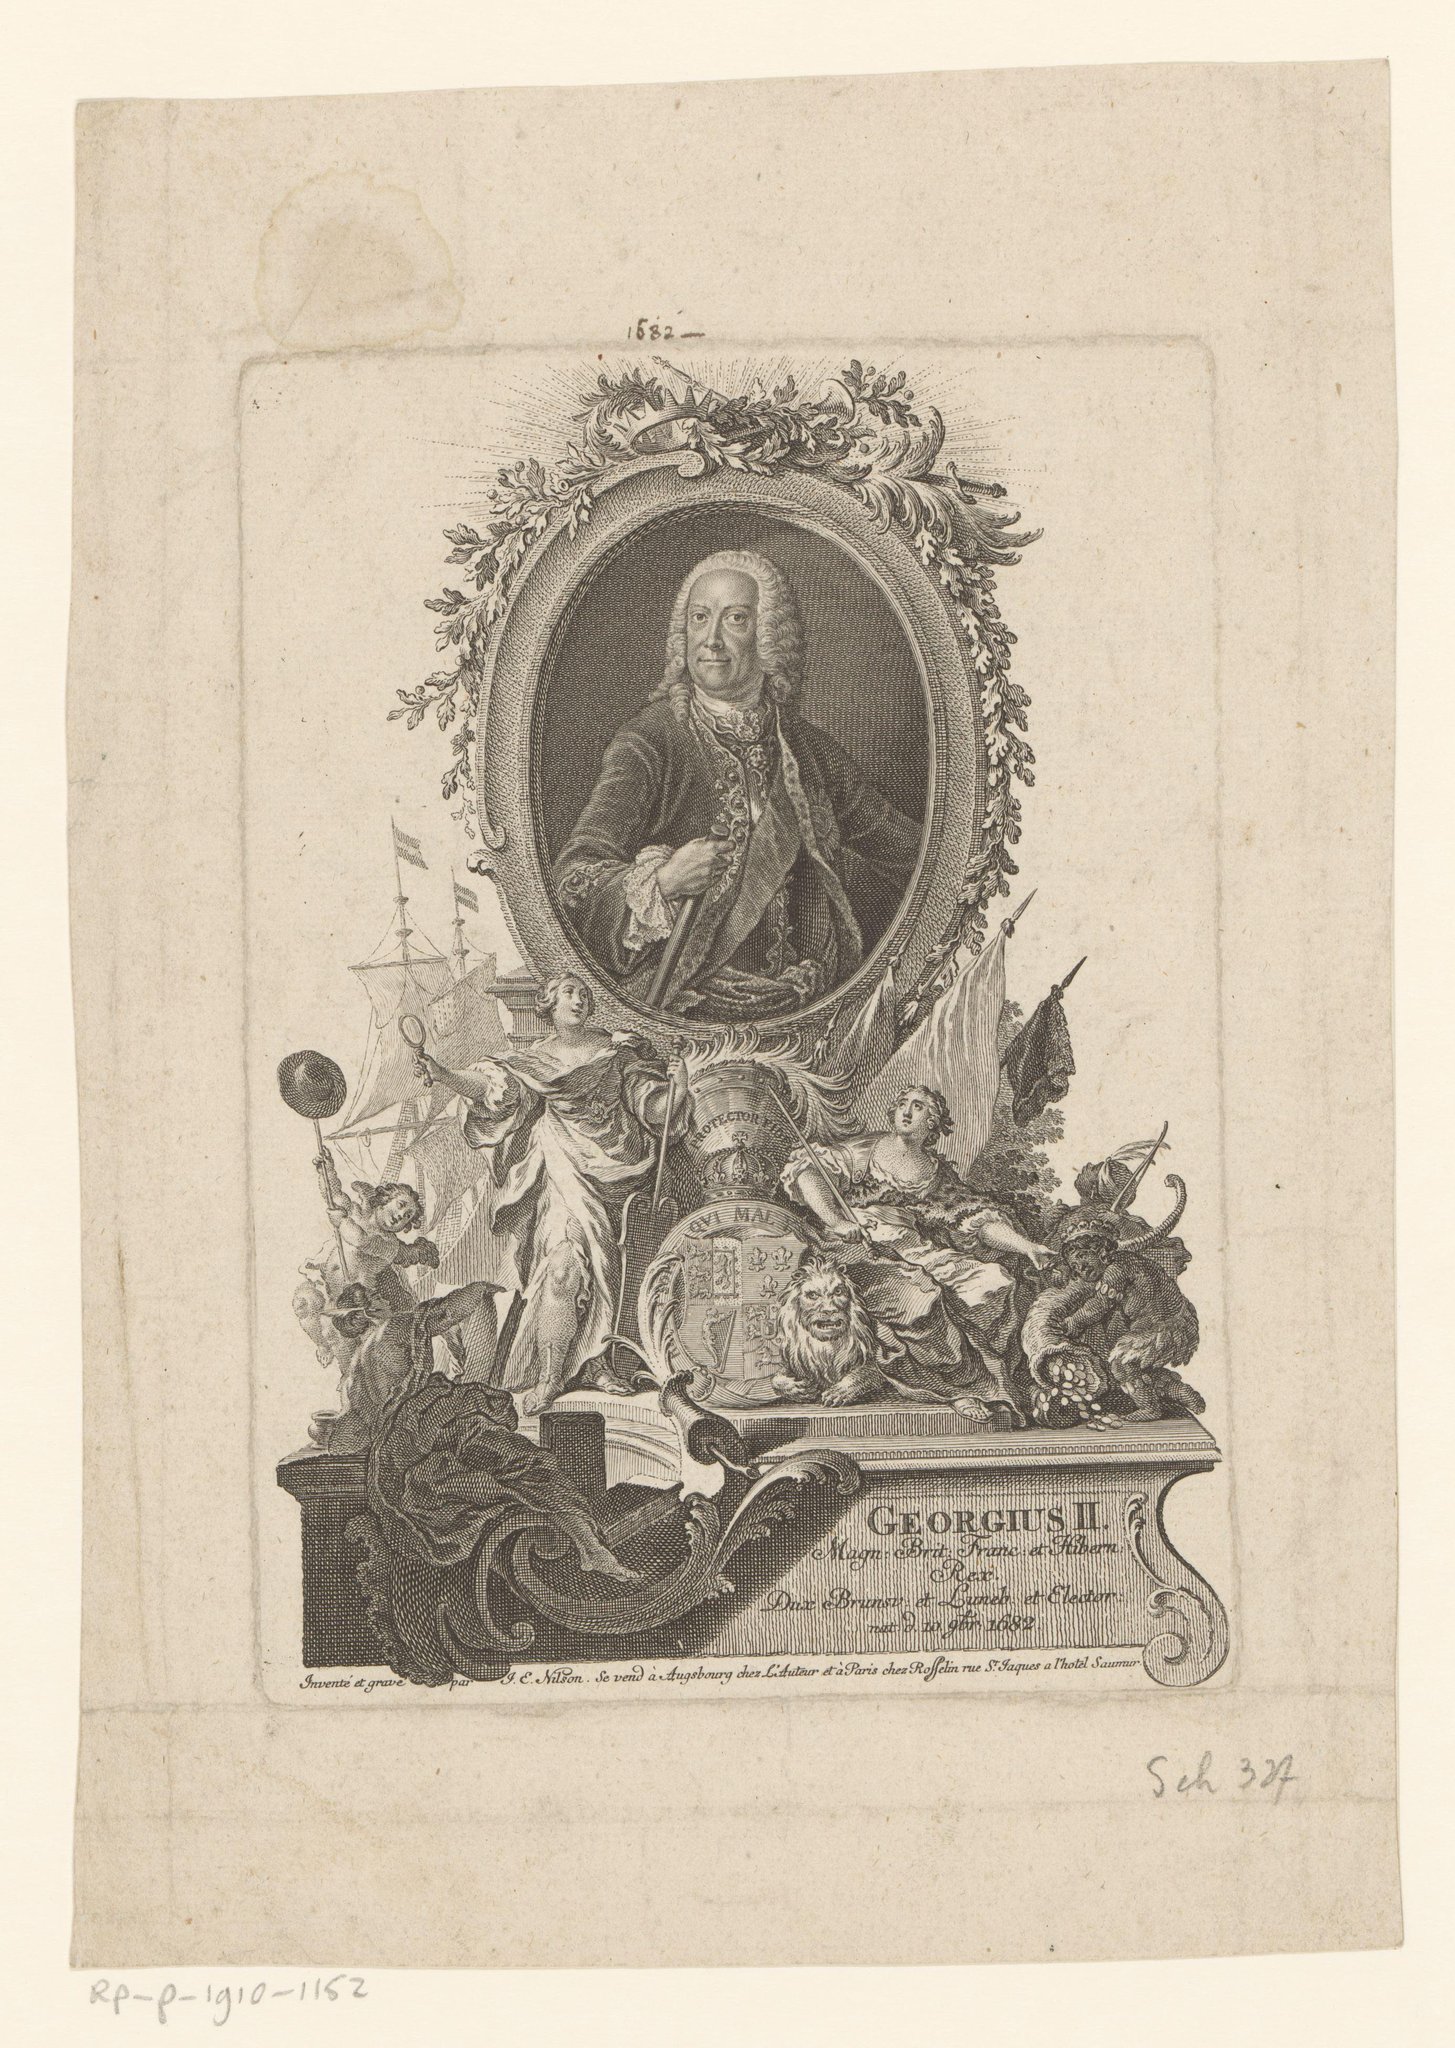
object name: print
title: Portret van George II, koning van Groot-Brittannië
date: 1731-1788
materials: paper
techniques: engraving, etching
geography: augsburg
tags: london, 'cornucopia', horn of plenty, sailing-ship, sailing-boat, symbols, allegories of peace, 'pax'; 'pace' (ripa), africans, historical persons, beasts of prey, predatory animals: lion, baton of general, armorial bearing, heraldry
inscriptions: collector's mark: Lugt 2228